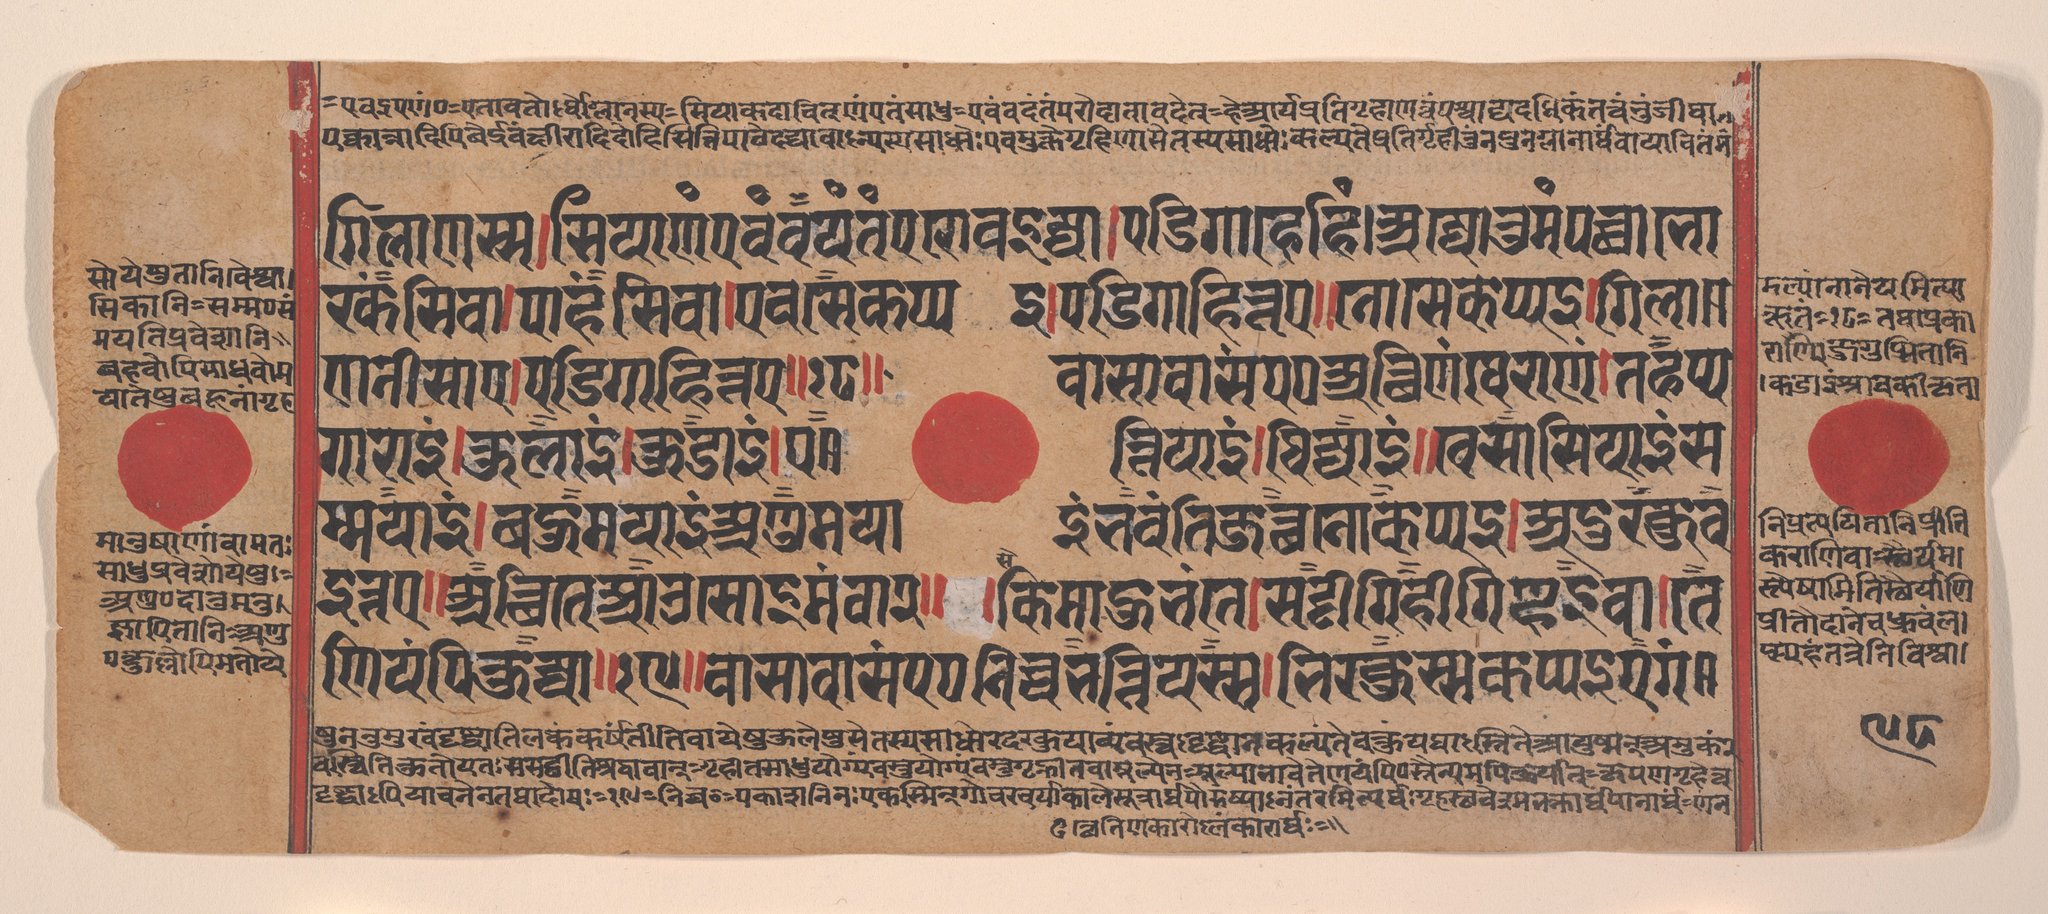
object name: folio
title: Page from a Dispersed Kalpa Sutra (Jain Book of Rituals)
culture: indian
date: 1401-1500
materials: gold, ink, paper, watercolor